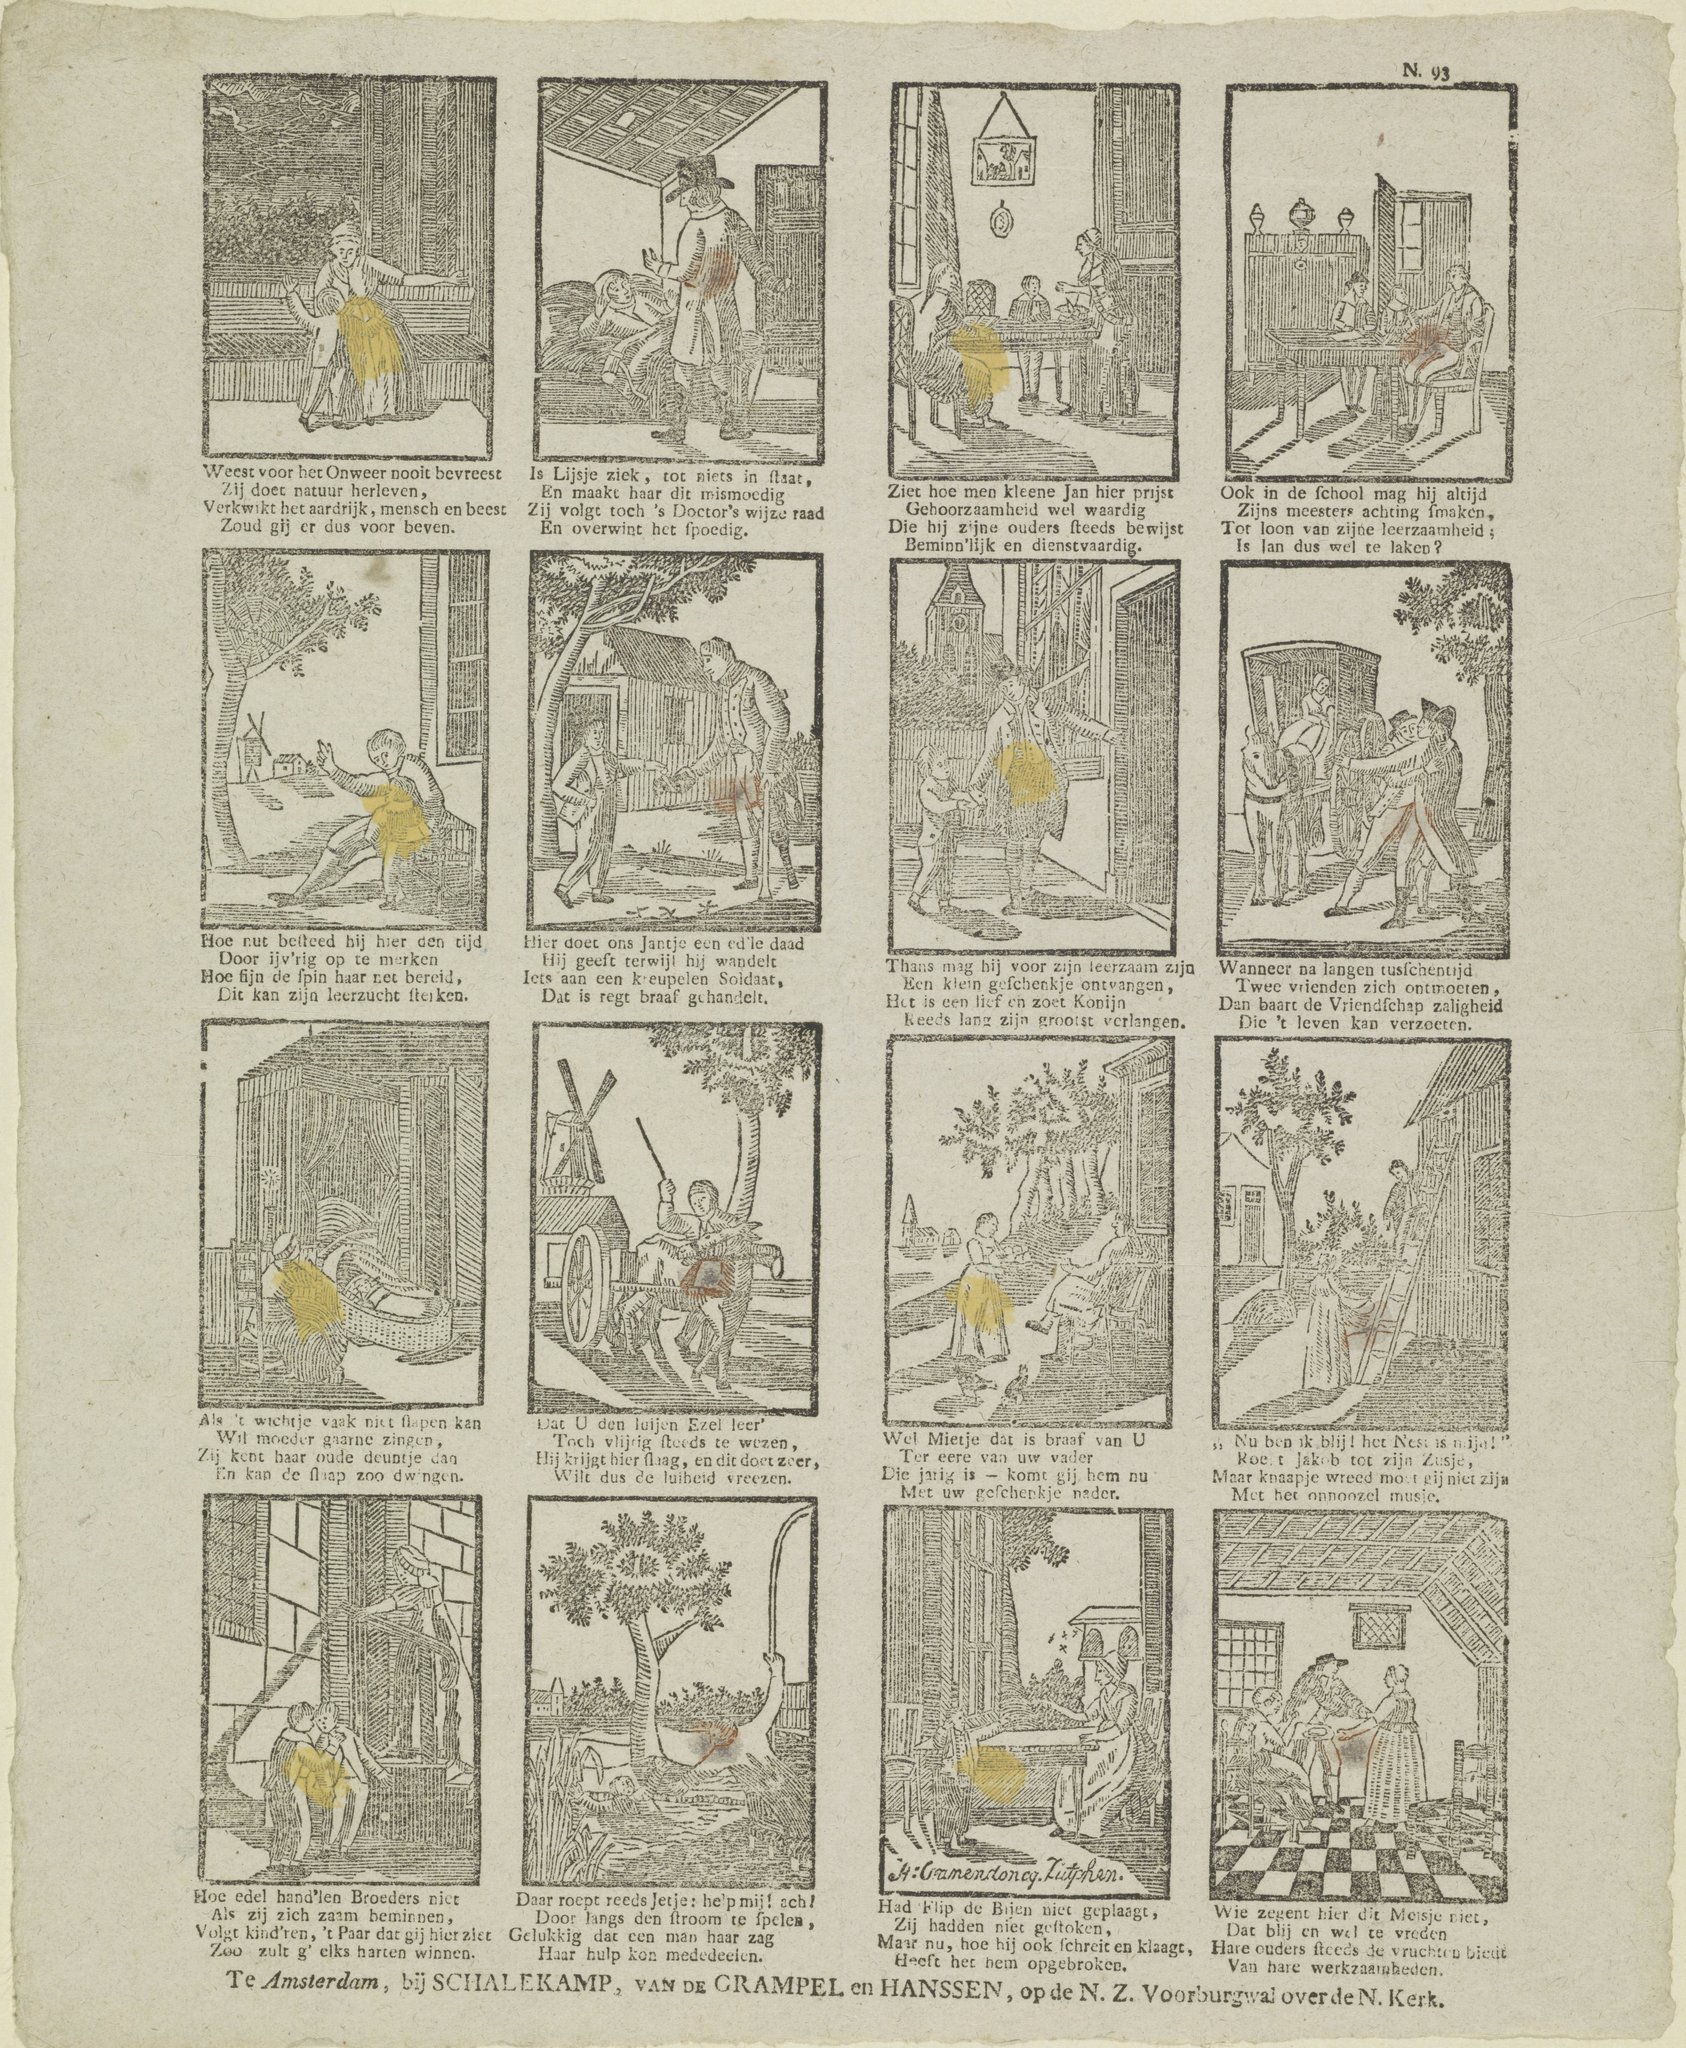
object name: popular print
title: Kinderleven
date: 1822-1849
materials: paper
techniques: colour, letterpress printing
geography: zutphen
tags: child, four-wheeled, animal-drawn vehicle, e.g.: cab, carriage, coach, physician, doctor, thunderstorm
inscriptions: collector's mark: Lugt 2760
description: Blad met 16 voorstellingen van verschillende aard, waaronder taferelen uit het kinderleven. Onder elke afbeelding een vierregelig vers. Genummerd rechtsboven: N. 93.